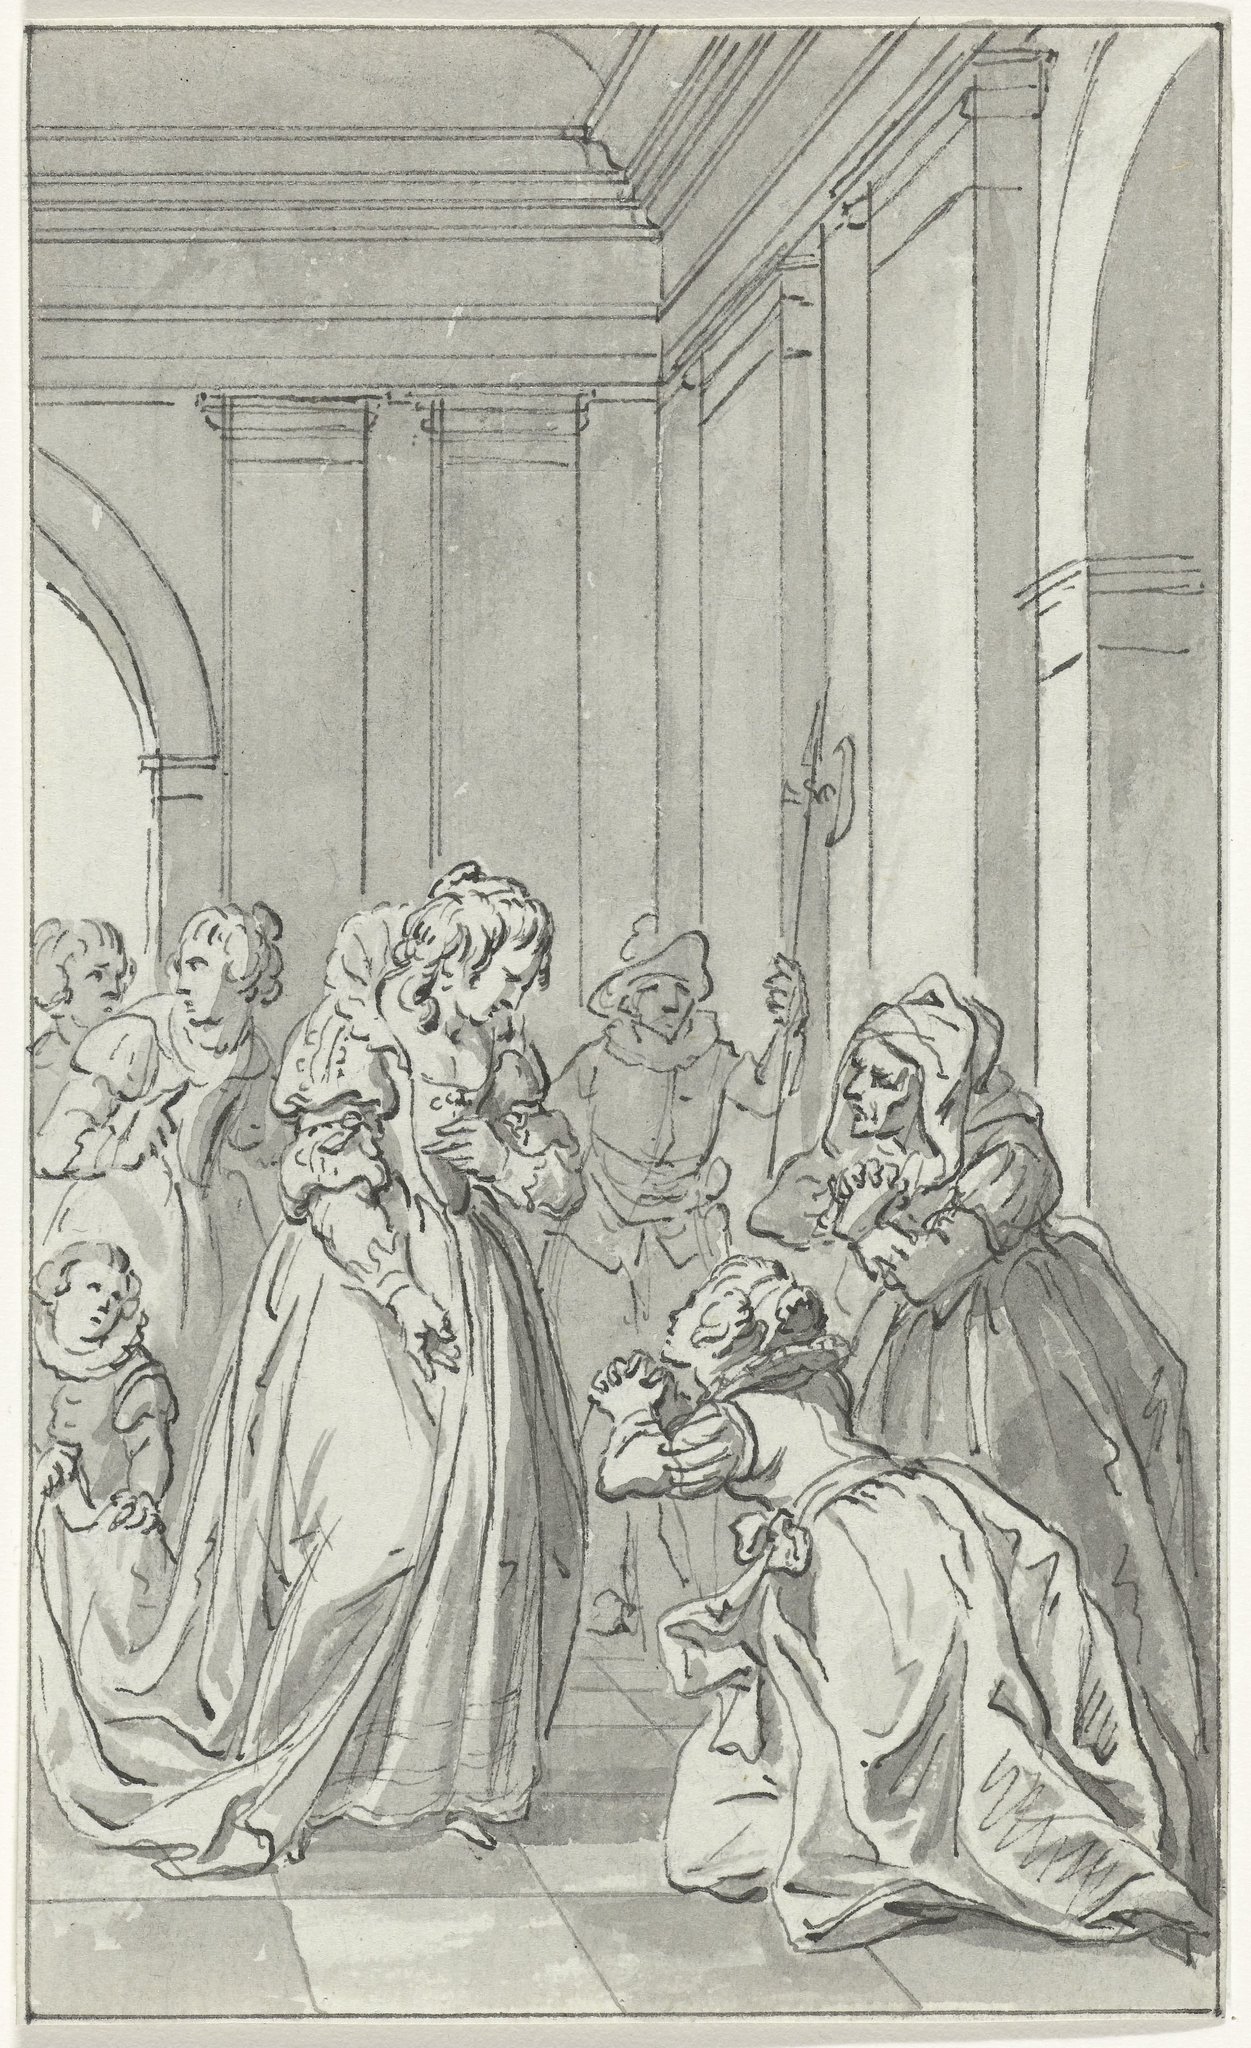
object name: historieplaat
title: De vrouw en de moeder van Floris de Montmorency, baron de Montigny, smeken Anna van Oostenrijk om voorspraak voor Montigny, die in Spanje gevangen gehouden wordt.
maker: jacobus buys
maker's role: draughtsman, print maker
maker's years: 1724-1801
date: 1788-1790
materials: ink, paper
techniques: brush, pen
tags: historical persons, historical events and situations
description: De vrouw en moeder van Montigny smeken bij Anna van Oostenrijk, bruid van koning Filips II, om voorspraak bij de koning voor de in Spanje gevangen Montigny, augustus 1570. Ontwerp voor een prent.